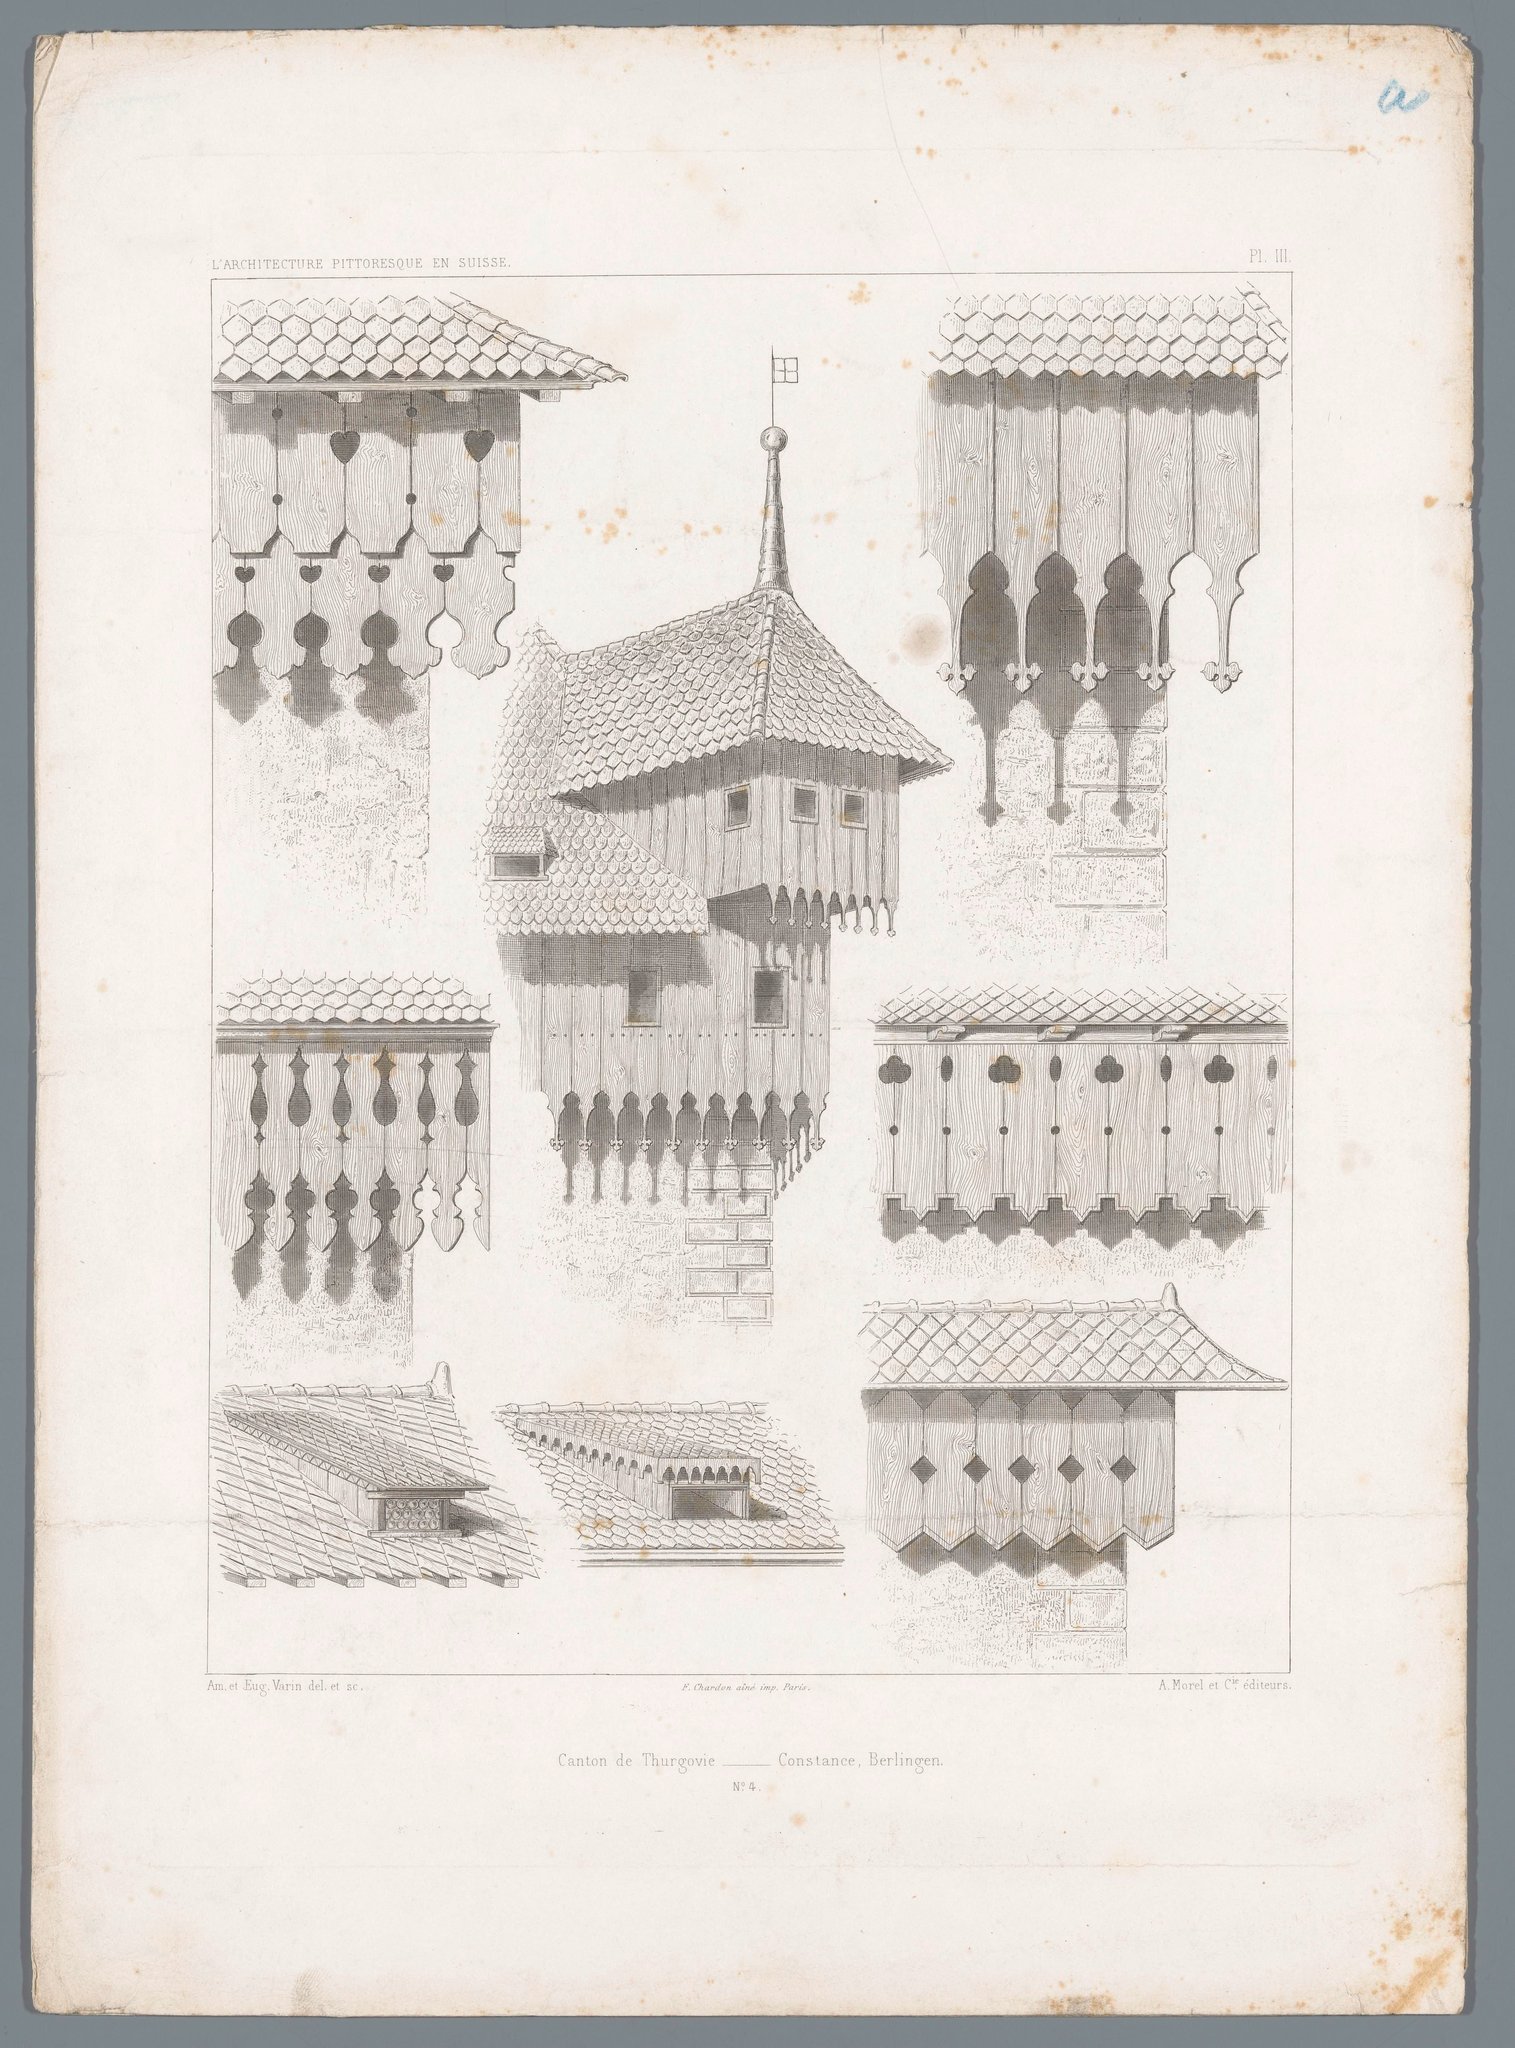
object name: print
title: Acht gezichten op decoratieve details langs daken van een huis in het kanton Thurgau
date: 1860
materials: paper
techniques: engraving, etching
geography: france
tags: architectural detail, rural housing, e.g. country-house, villa, cottage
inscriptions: inscription: ‘a’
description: Prent afkomstig uit een serie van 48 prenten, uitgegeven tussen 1660-1661 in twaalf delen, getiteld: L'architecture pittoresque en Suisse ou choix de constructions rustiques prises dans toutes les parties de la Suisse. De serie bestaat uit aanzichten en details van traditionele Zwitserse huizen.